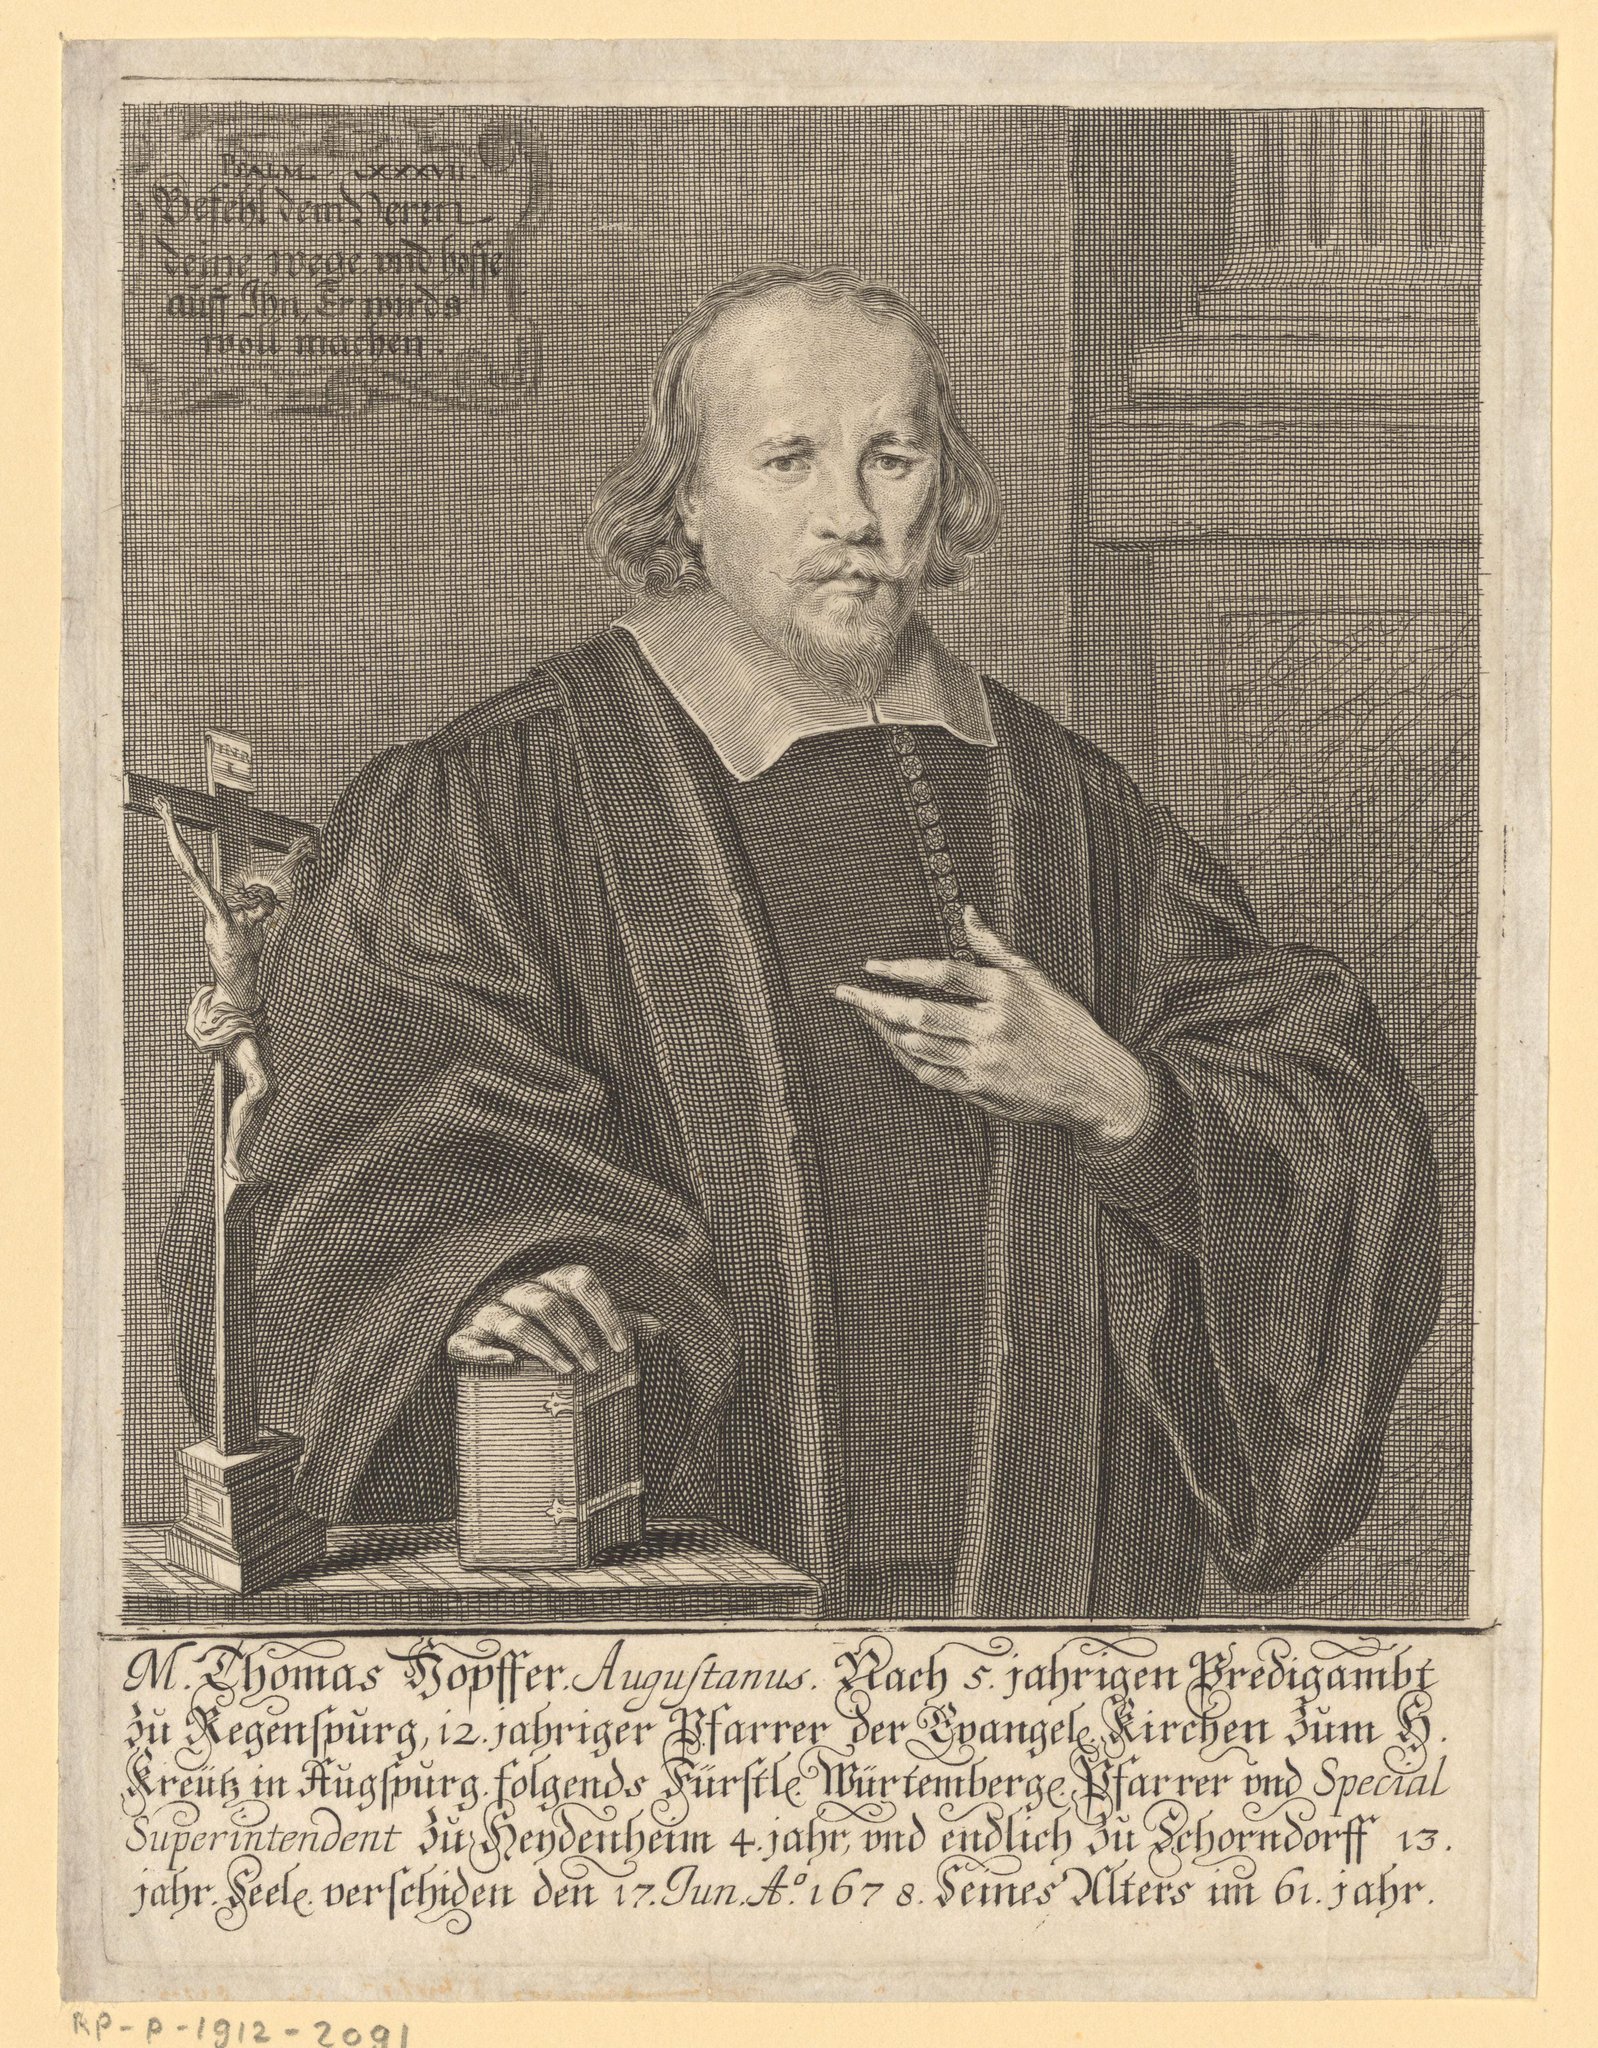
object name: print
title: Portret van Thomas Hopffer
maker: bartholomäus kilian (ii)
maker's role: artist, draughtsman, print maker, publisher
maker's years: 1630-1696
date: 1668-1696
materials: paper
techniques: engraving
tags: augsburg, altarcross, crucifix, theologian, historical persons, book